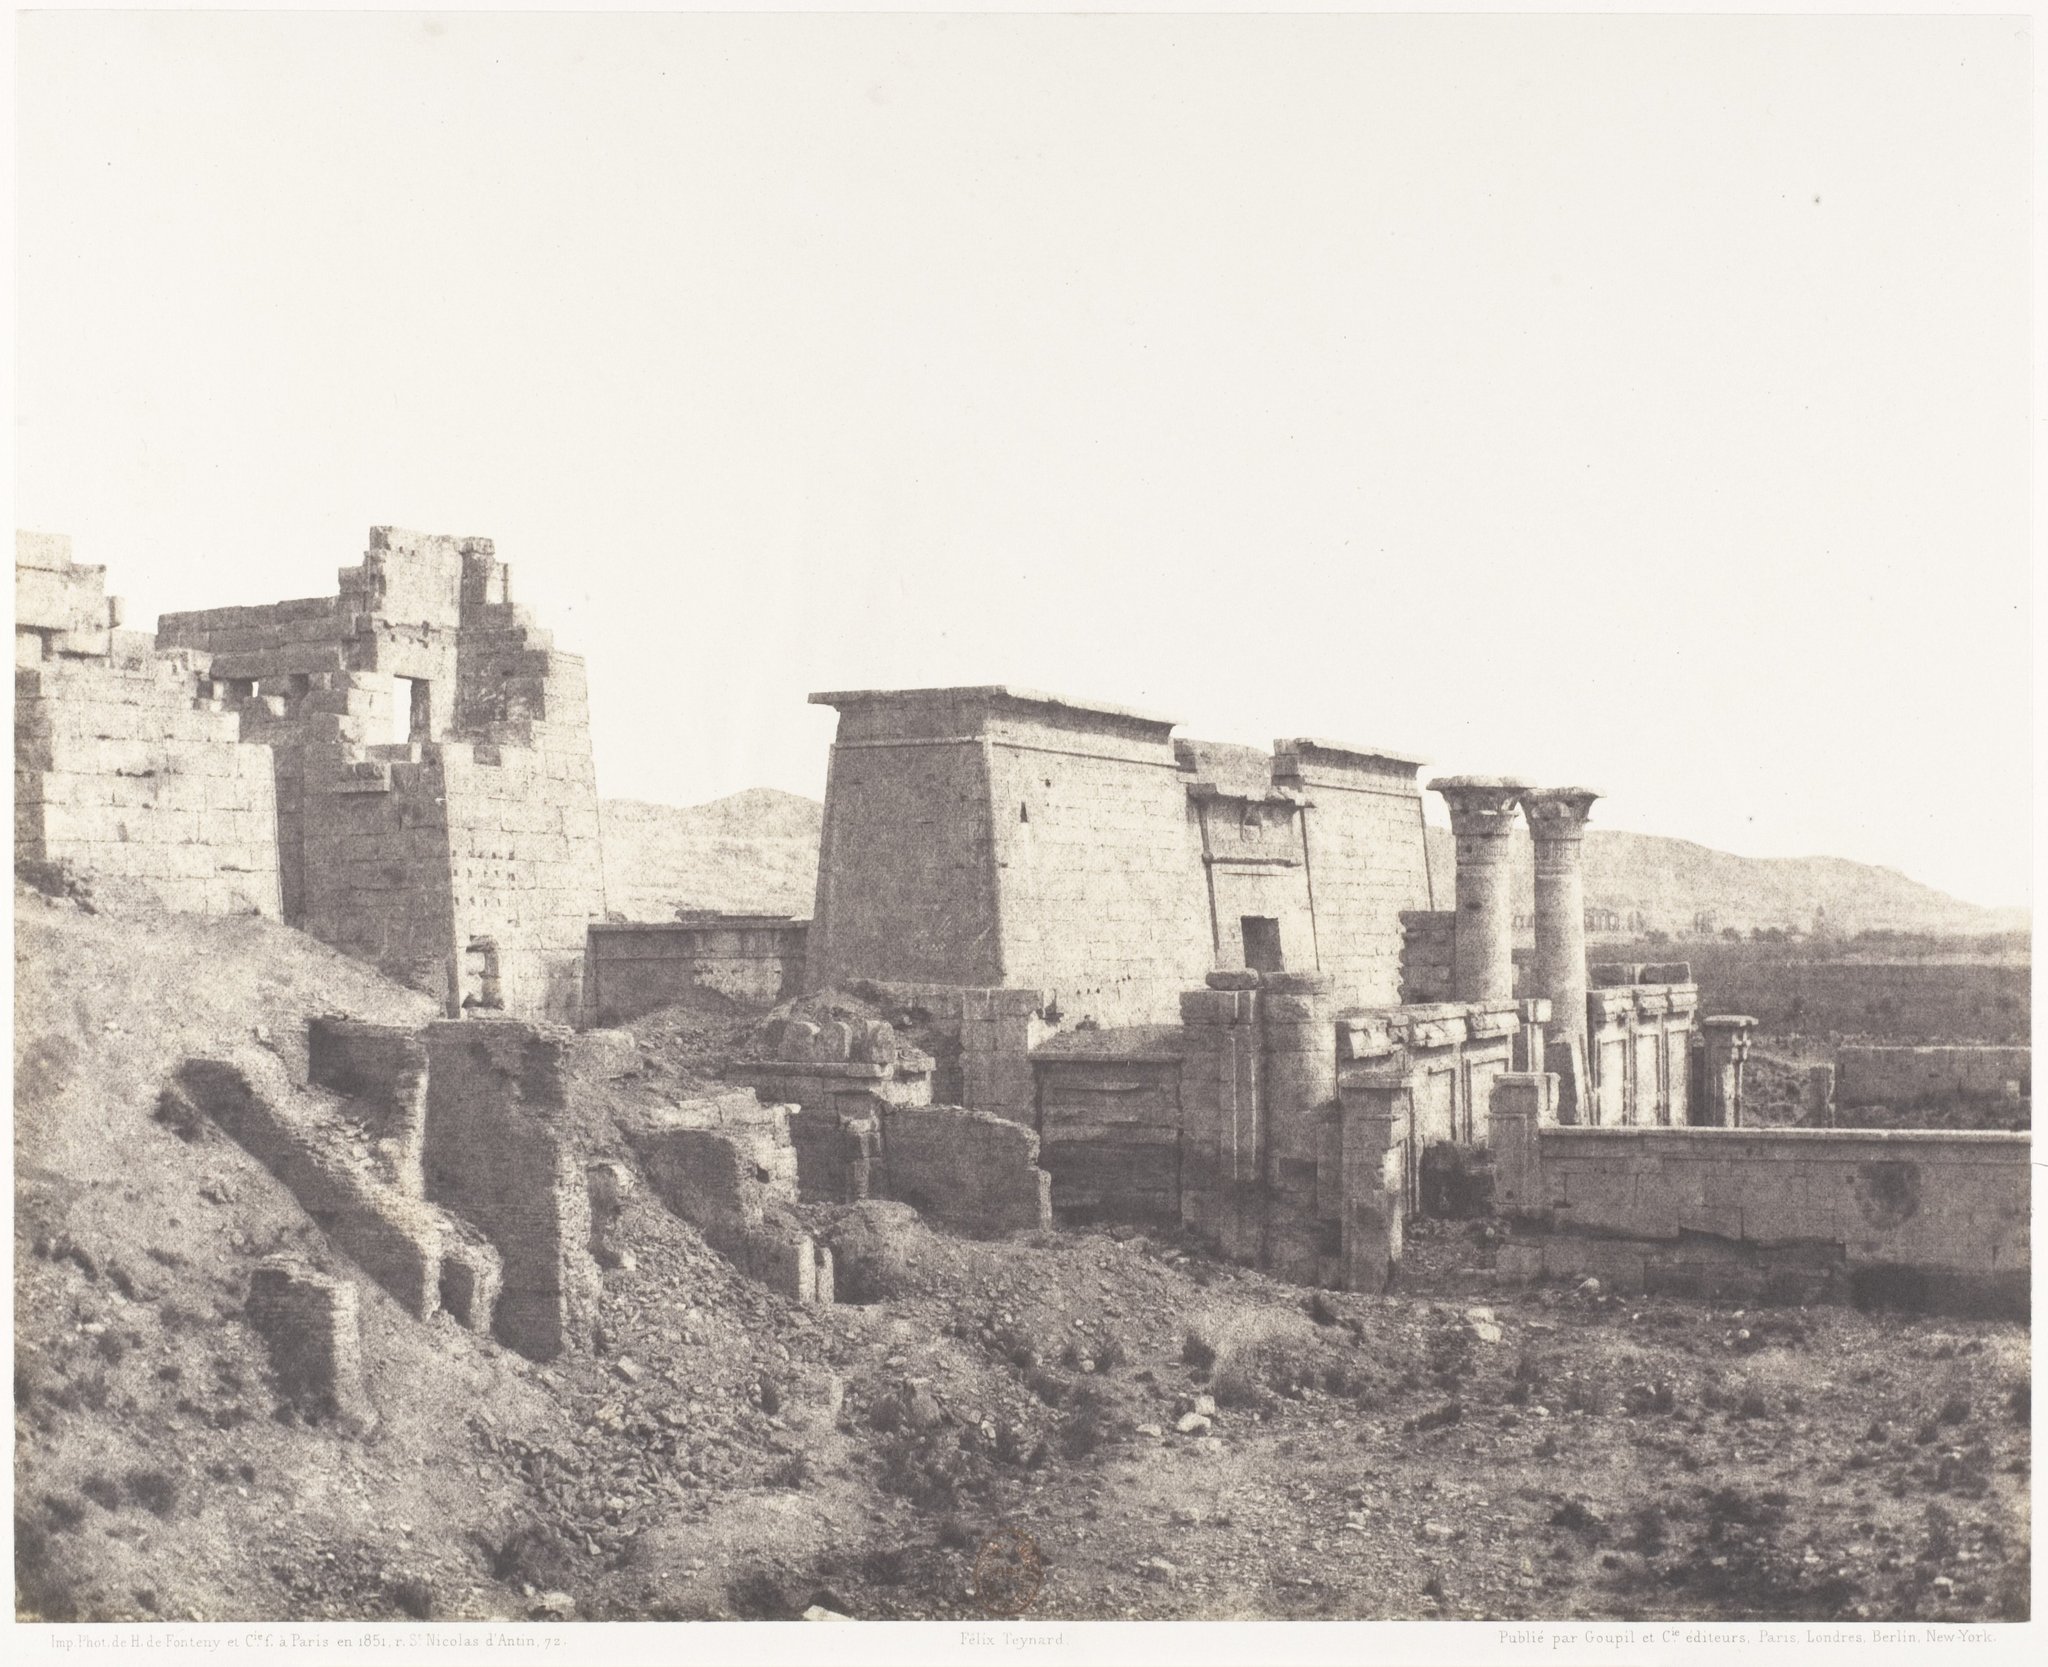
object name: photograph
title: Médînet-Abou (Thèbes), Construction Antérieures - Vue Générale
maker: félix teynard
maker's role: artist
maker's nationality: french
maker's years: 1817-1892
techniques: paper negative, salted paper print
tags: architecture,ruins